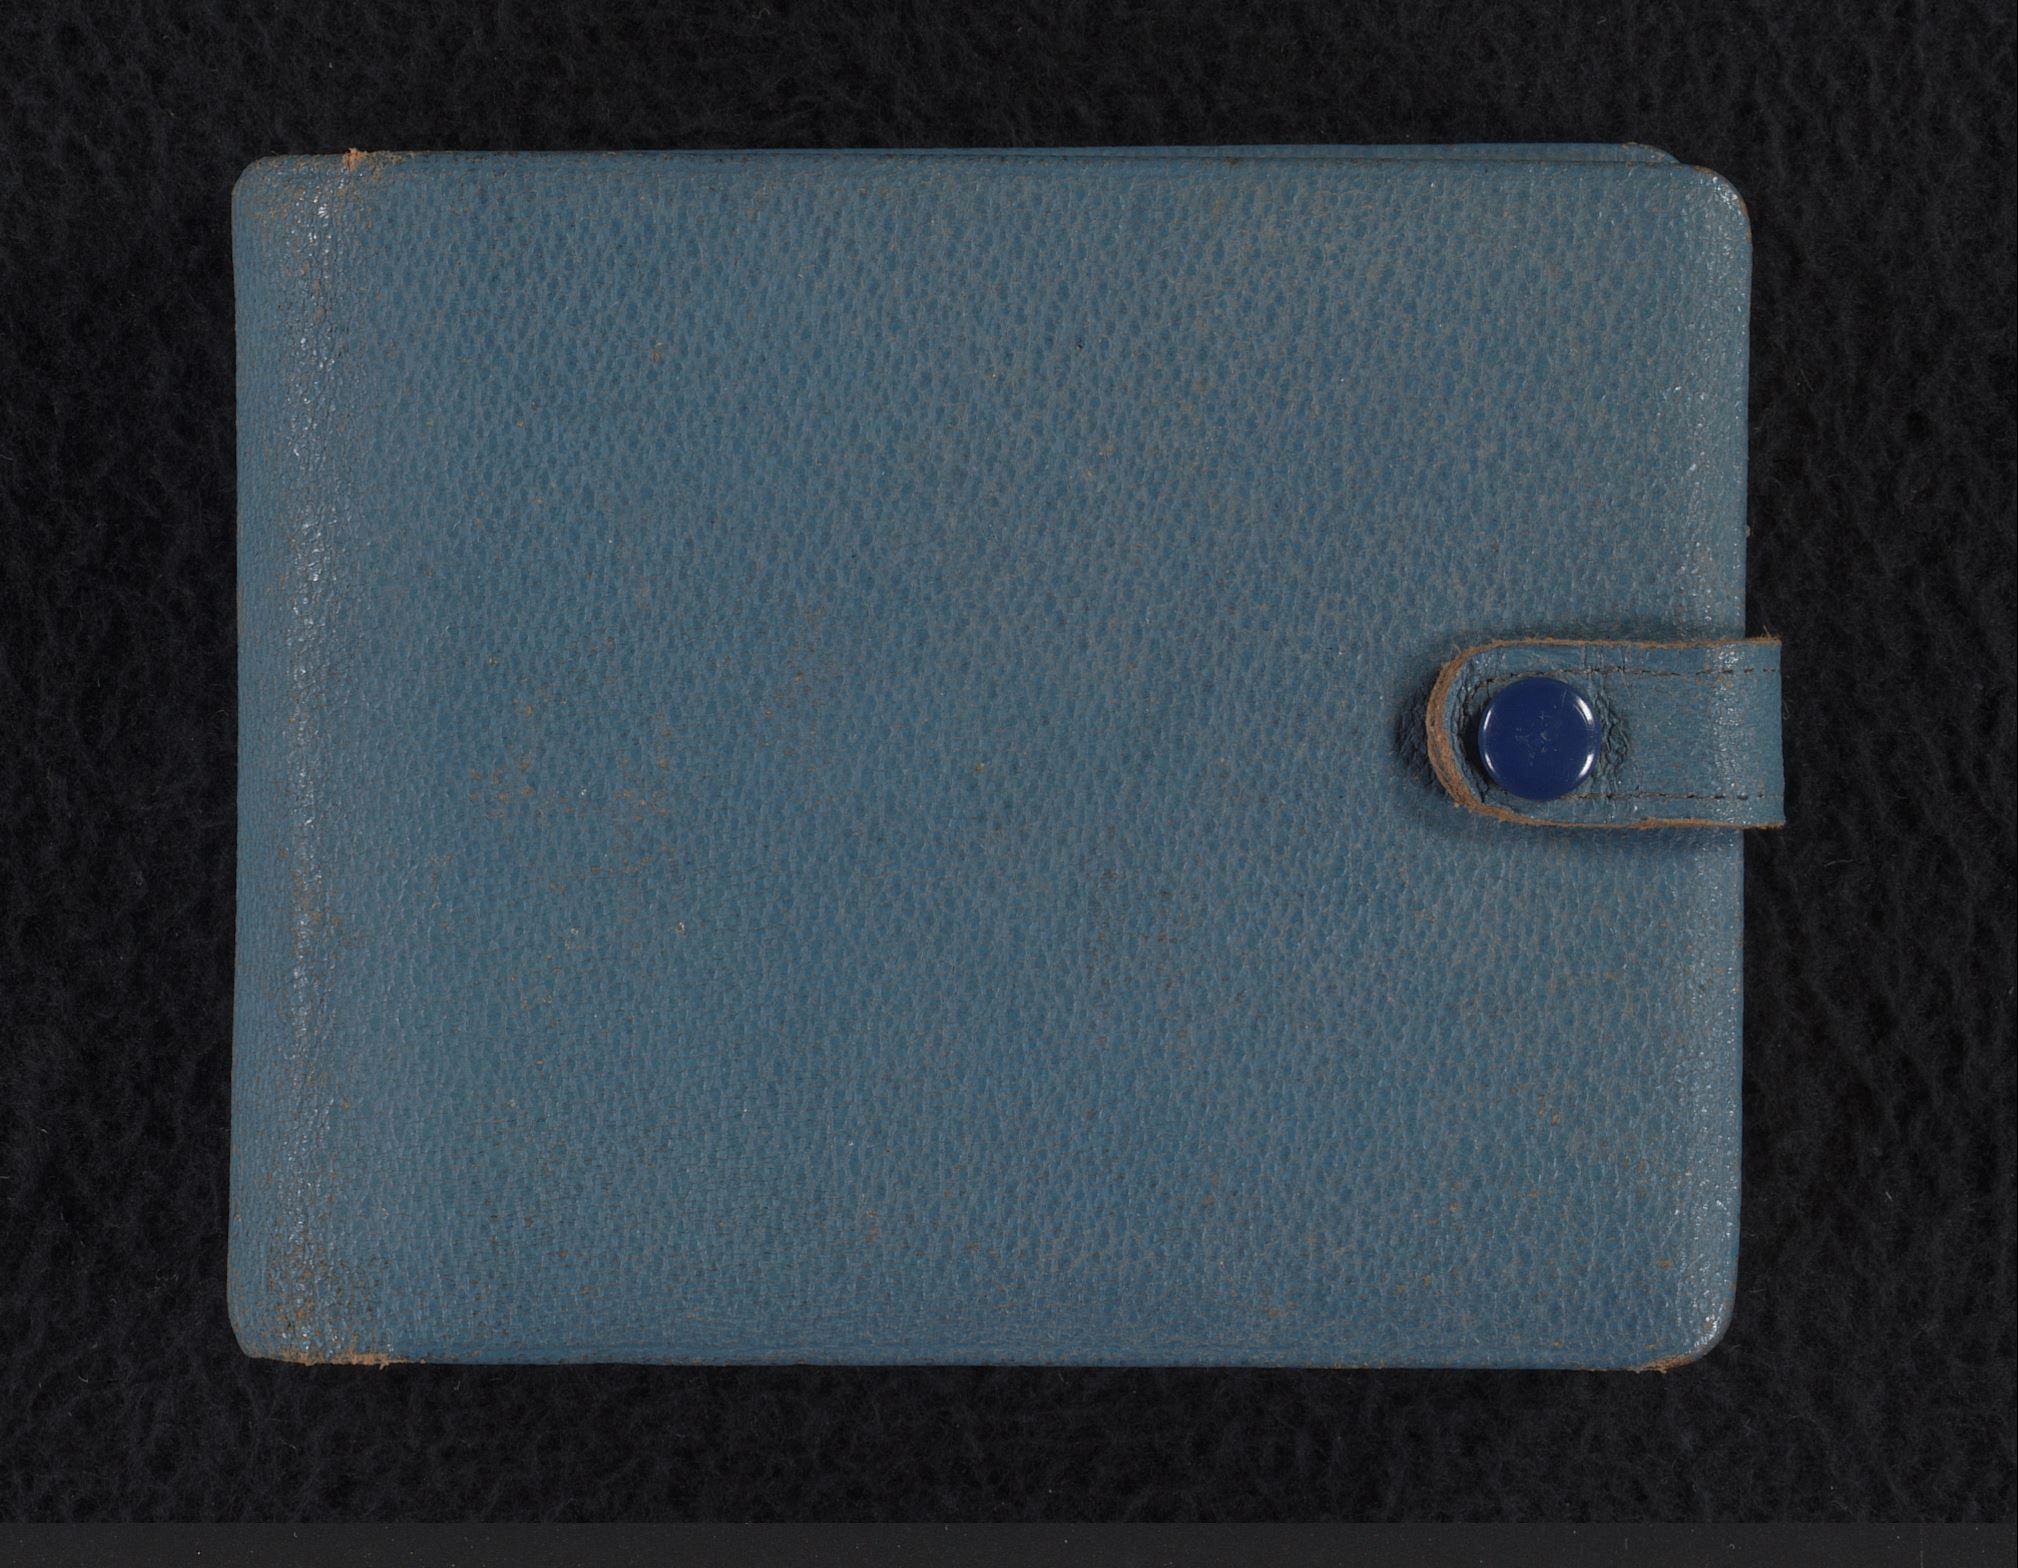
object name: photograph album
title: Fotoalbum met verzameling foto's uit de privé-sfeer van de familie Wachenheimer, genomen tussen 1935 en 1939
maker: else wachenheimer-moos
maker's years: 1895-1944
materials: leather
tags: eugen wachenheimer, else wachenheimer-moos, leiden, isabel wachenheimer-elon, rotterdam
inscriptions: factory mark: ‘"TeBe" Kleinbild-Album für Leica’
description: Bijschriften geschreven in het handschrift van Else Wachenheimer-Moos. Dit object is onderdeel van de nalatenschap van Isabel Elon-Wachenheimer (1928-2010). Tot haar overlijden behoorde het samen met de andere objecten uit de nalatenschap tot haar privédomein van Isabel Wachenheimer. In die particuliere context zijn deze objecten tezamen en individueel aandenkens - aan de jeugd, ouders en familie van Isabel Wachenheimer vóór en tijdens de Shoah en aan haar leven na de Tweede Wereldoorlog. Isabel Wachenheimer, die van juni 1943 tot mei 1945 gevangen zat in Kamp Westerbork, Theresienstadt, Auschwitz, Lenzing a/d Oberdonau (een buitenkamp van Mauthausen), overleefde de Shoah. Haar ouders – Eugène Wachenheimer en Else Wachenheimer-Moos - werden op 14 oktober 1944 in Auschwitz-Birkenau vermoord.